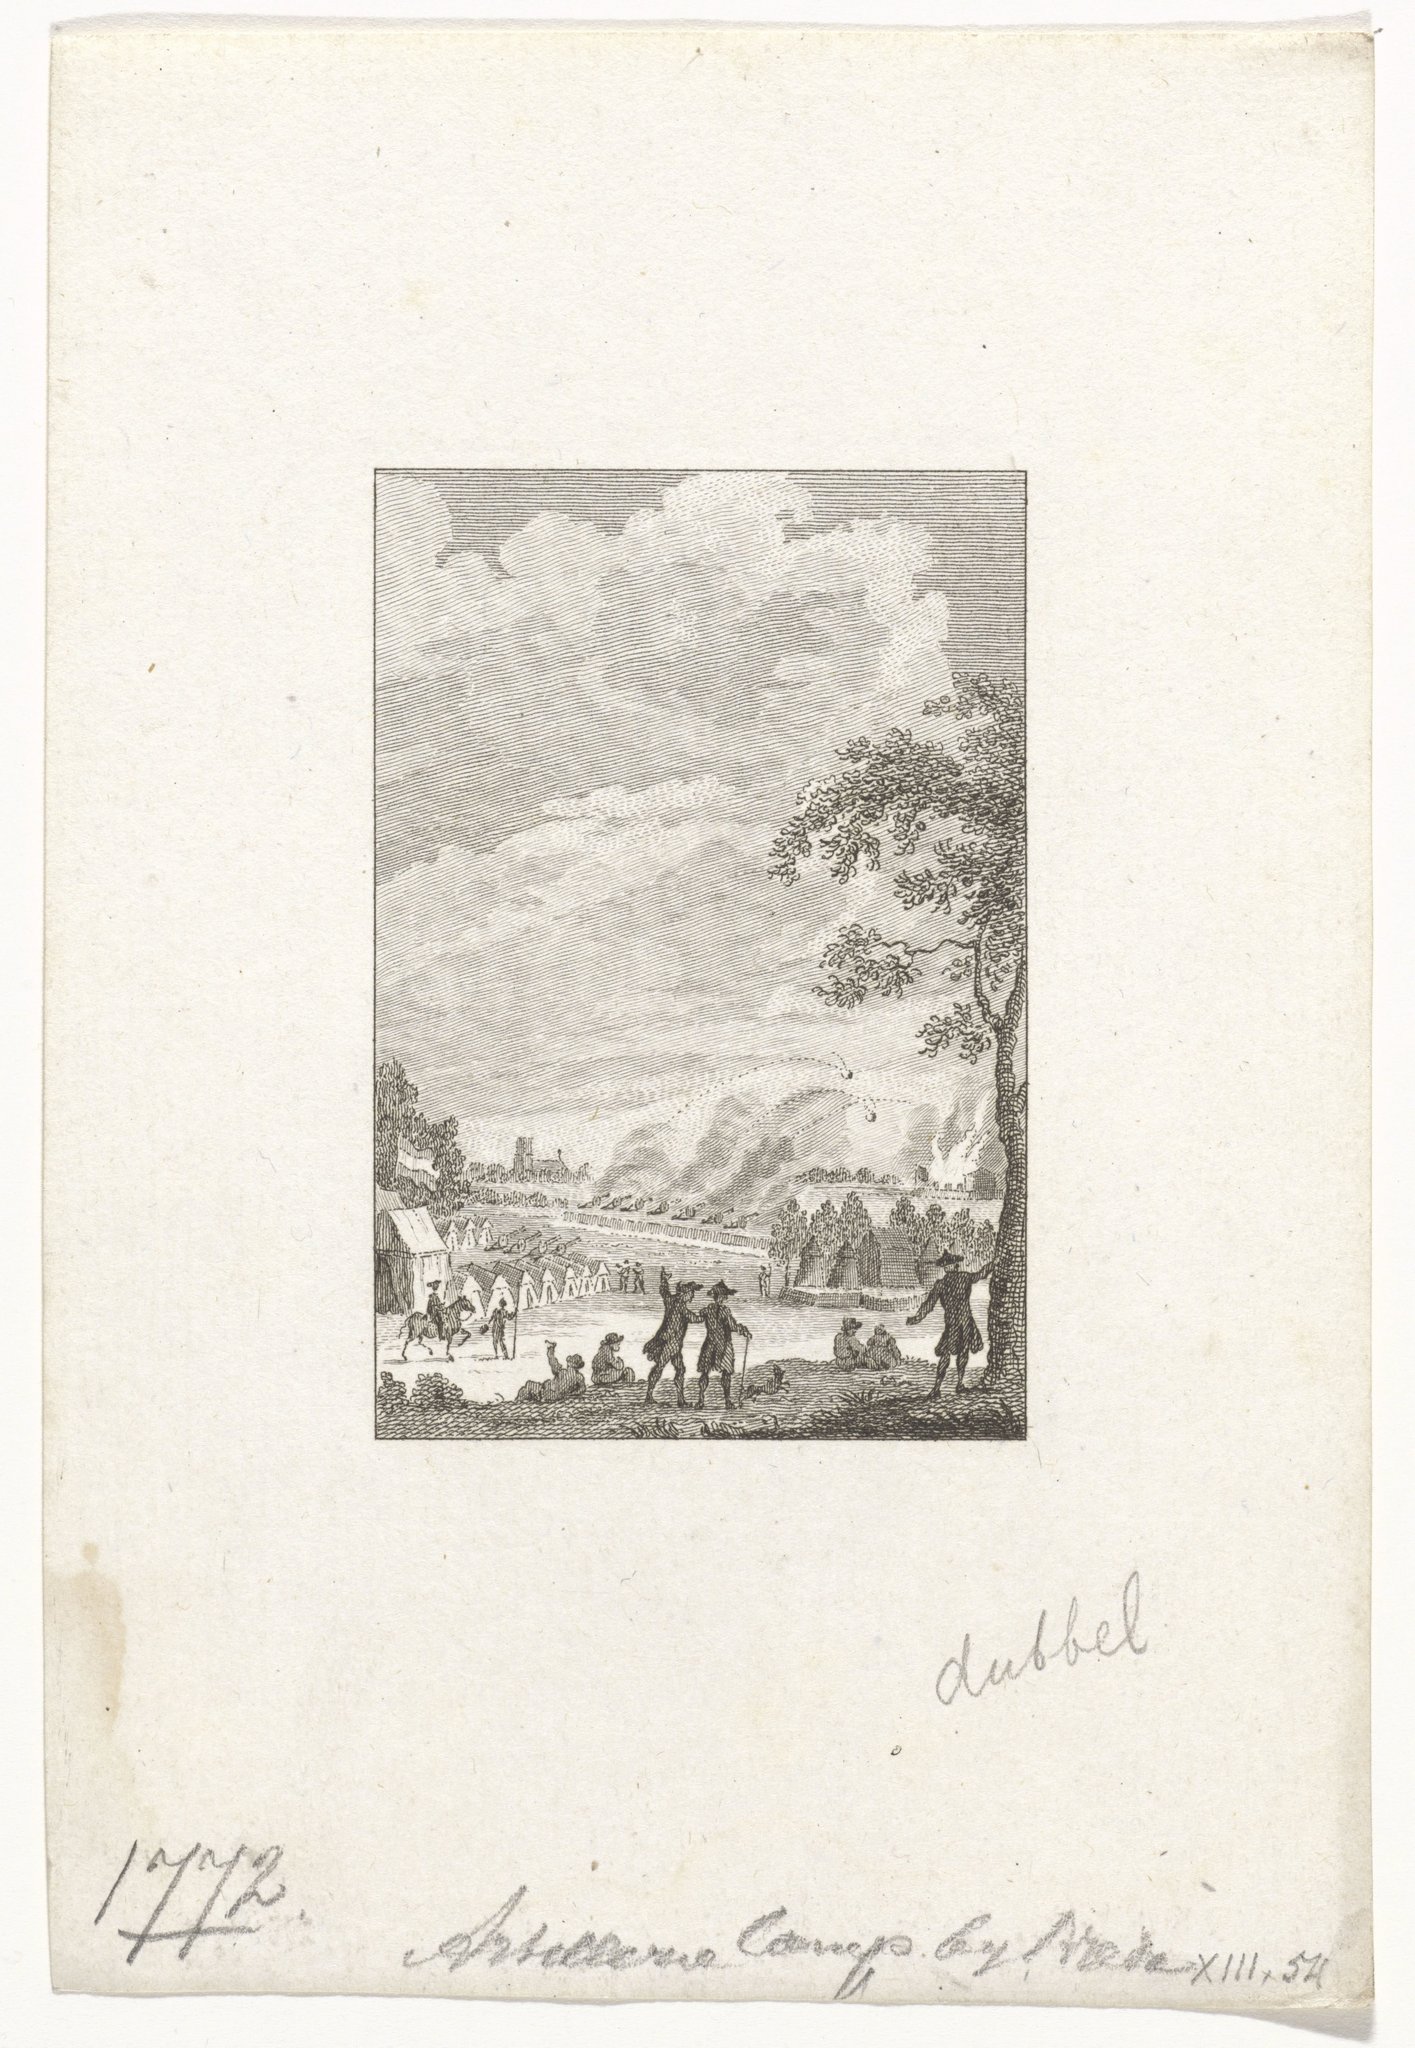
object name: history print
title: Kampement van het Staatse Leger bij Breda, 1769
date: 1783-1795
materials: paper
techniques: etching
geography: amsterdam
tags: manoeuvre ~ military training (+ artillery)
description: Illustratie voor: J. Fokke. Geschiedenissen der Vereenigde Nederlanden voor de vaderlandsche jeugd. Amsterdam: Johannes Allart, 1783-1795, 25 delen. deel XIII.